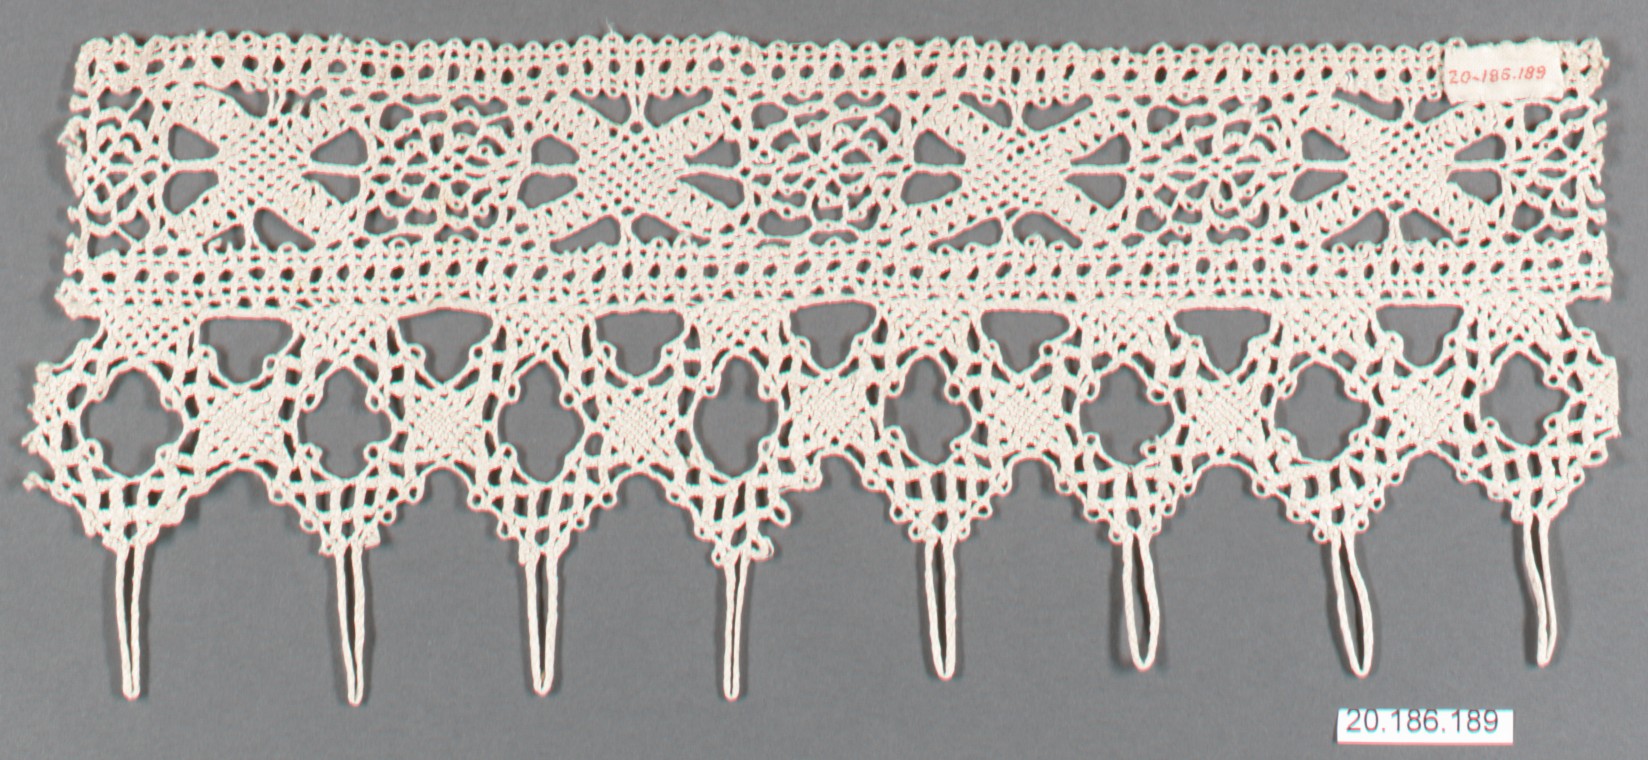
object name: edging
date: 1501-1550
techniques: lace